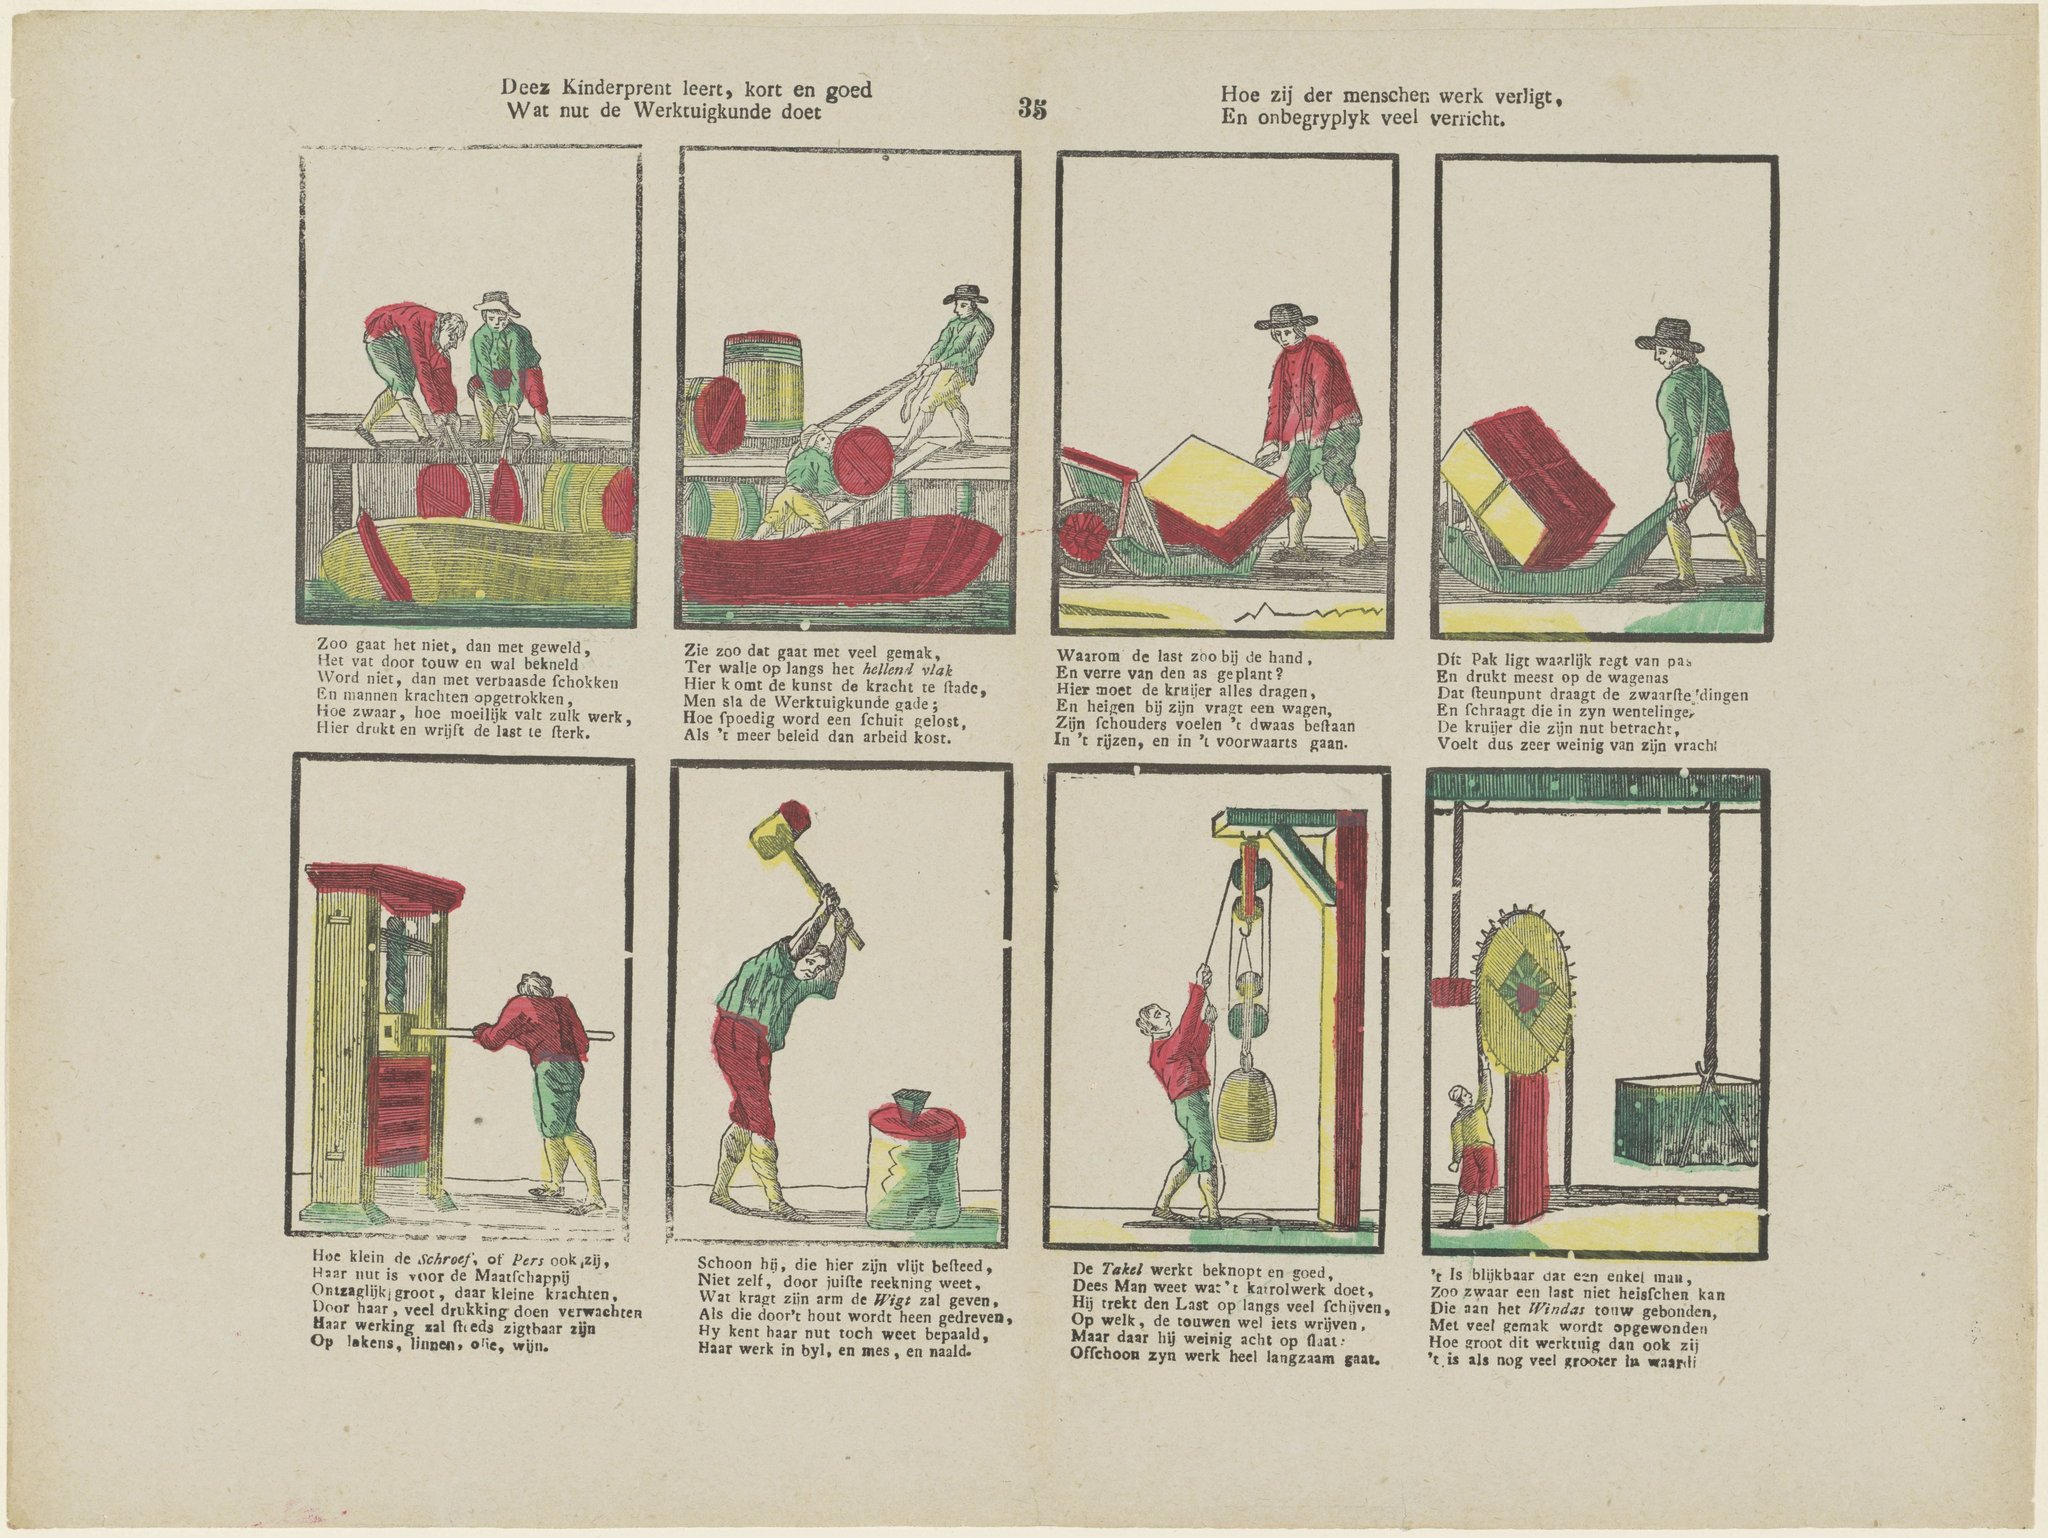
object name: popular print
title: Deez kinderprent leert, kort en goed / Wat nut de werktuigkunde doet / Hoe zij der menschen werk verligt, / En onbegryplyk veel verricht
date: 1866-1902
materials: paper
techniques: colour, letterpress printing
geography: europe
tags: tools and machines ~ building, printing press, dock crane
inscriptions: collector's mark: Lugt 2760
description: Blad met 8 voorstellingen van mannen die werktuigen gebruiken, zoals een pers en een hijskraan. Onder elke afbeelding een zesregelig vers. Genummerd midden boven: 35.